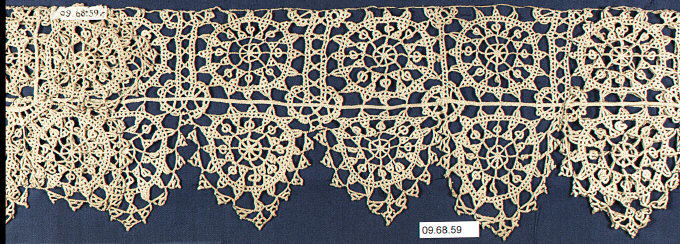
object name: border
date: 1600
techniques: lace